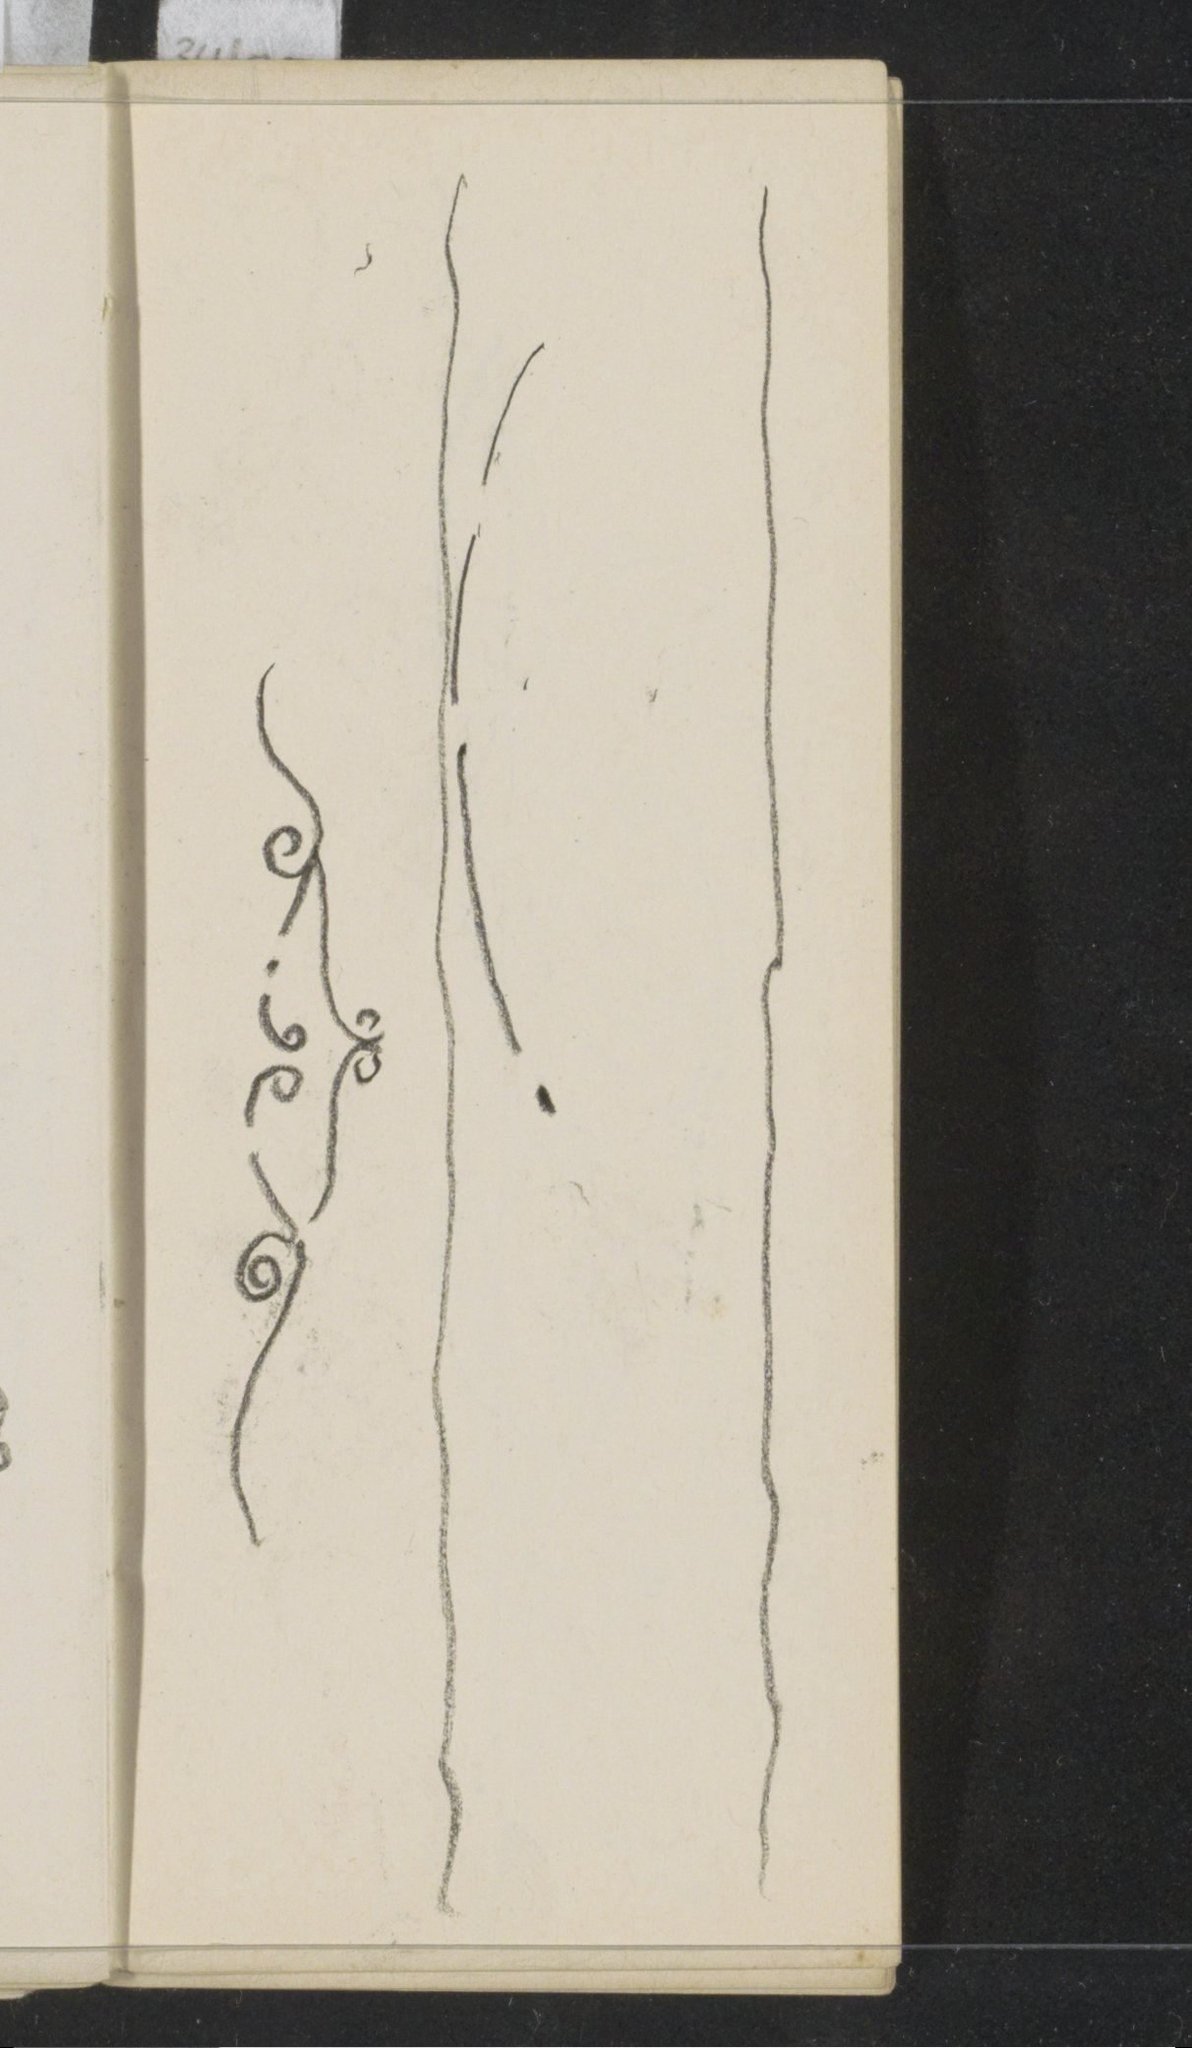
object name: sketchbook leaf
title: Ornament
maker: gerrit willem dijsselhof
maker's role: designer, draughtsman, print maker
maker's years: 1866-1924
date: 1901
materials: chalk, paper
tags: ornaments ~ art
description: Blad 26 recto uit een schetsboek met 42 bladzijden.